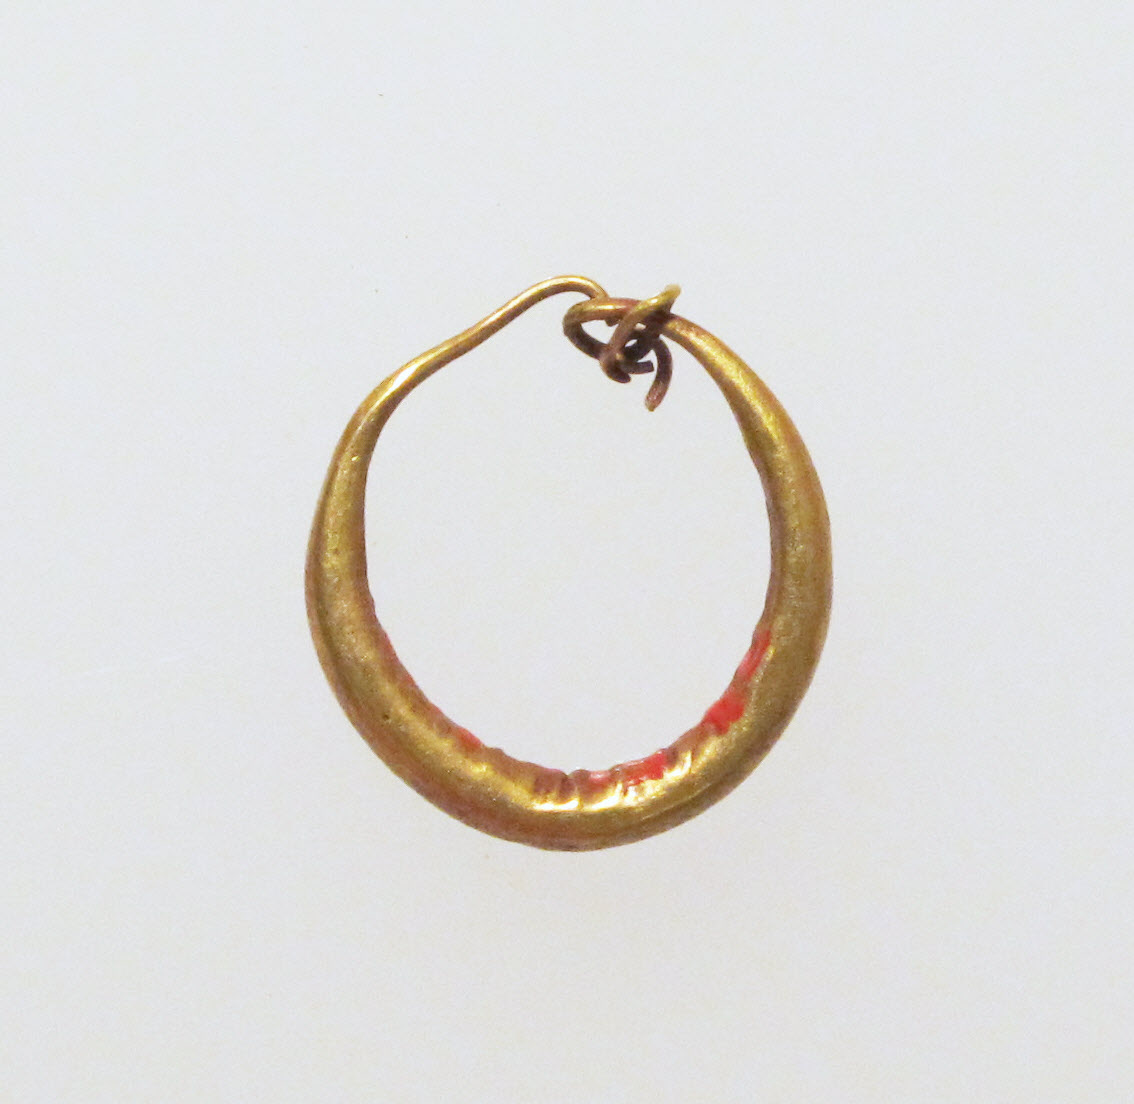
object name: earring loop type, plain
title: Earring-loop type, plain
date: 7000 BCE-330 CE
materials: gold